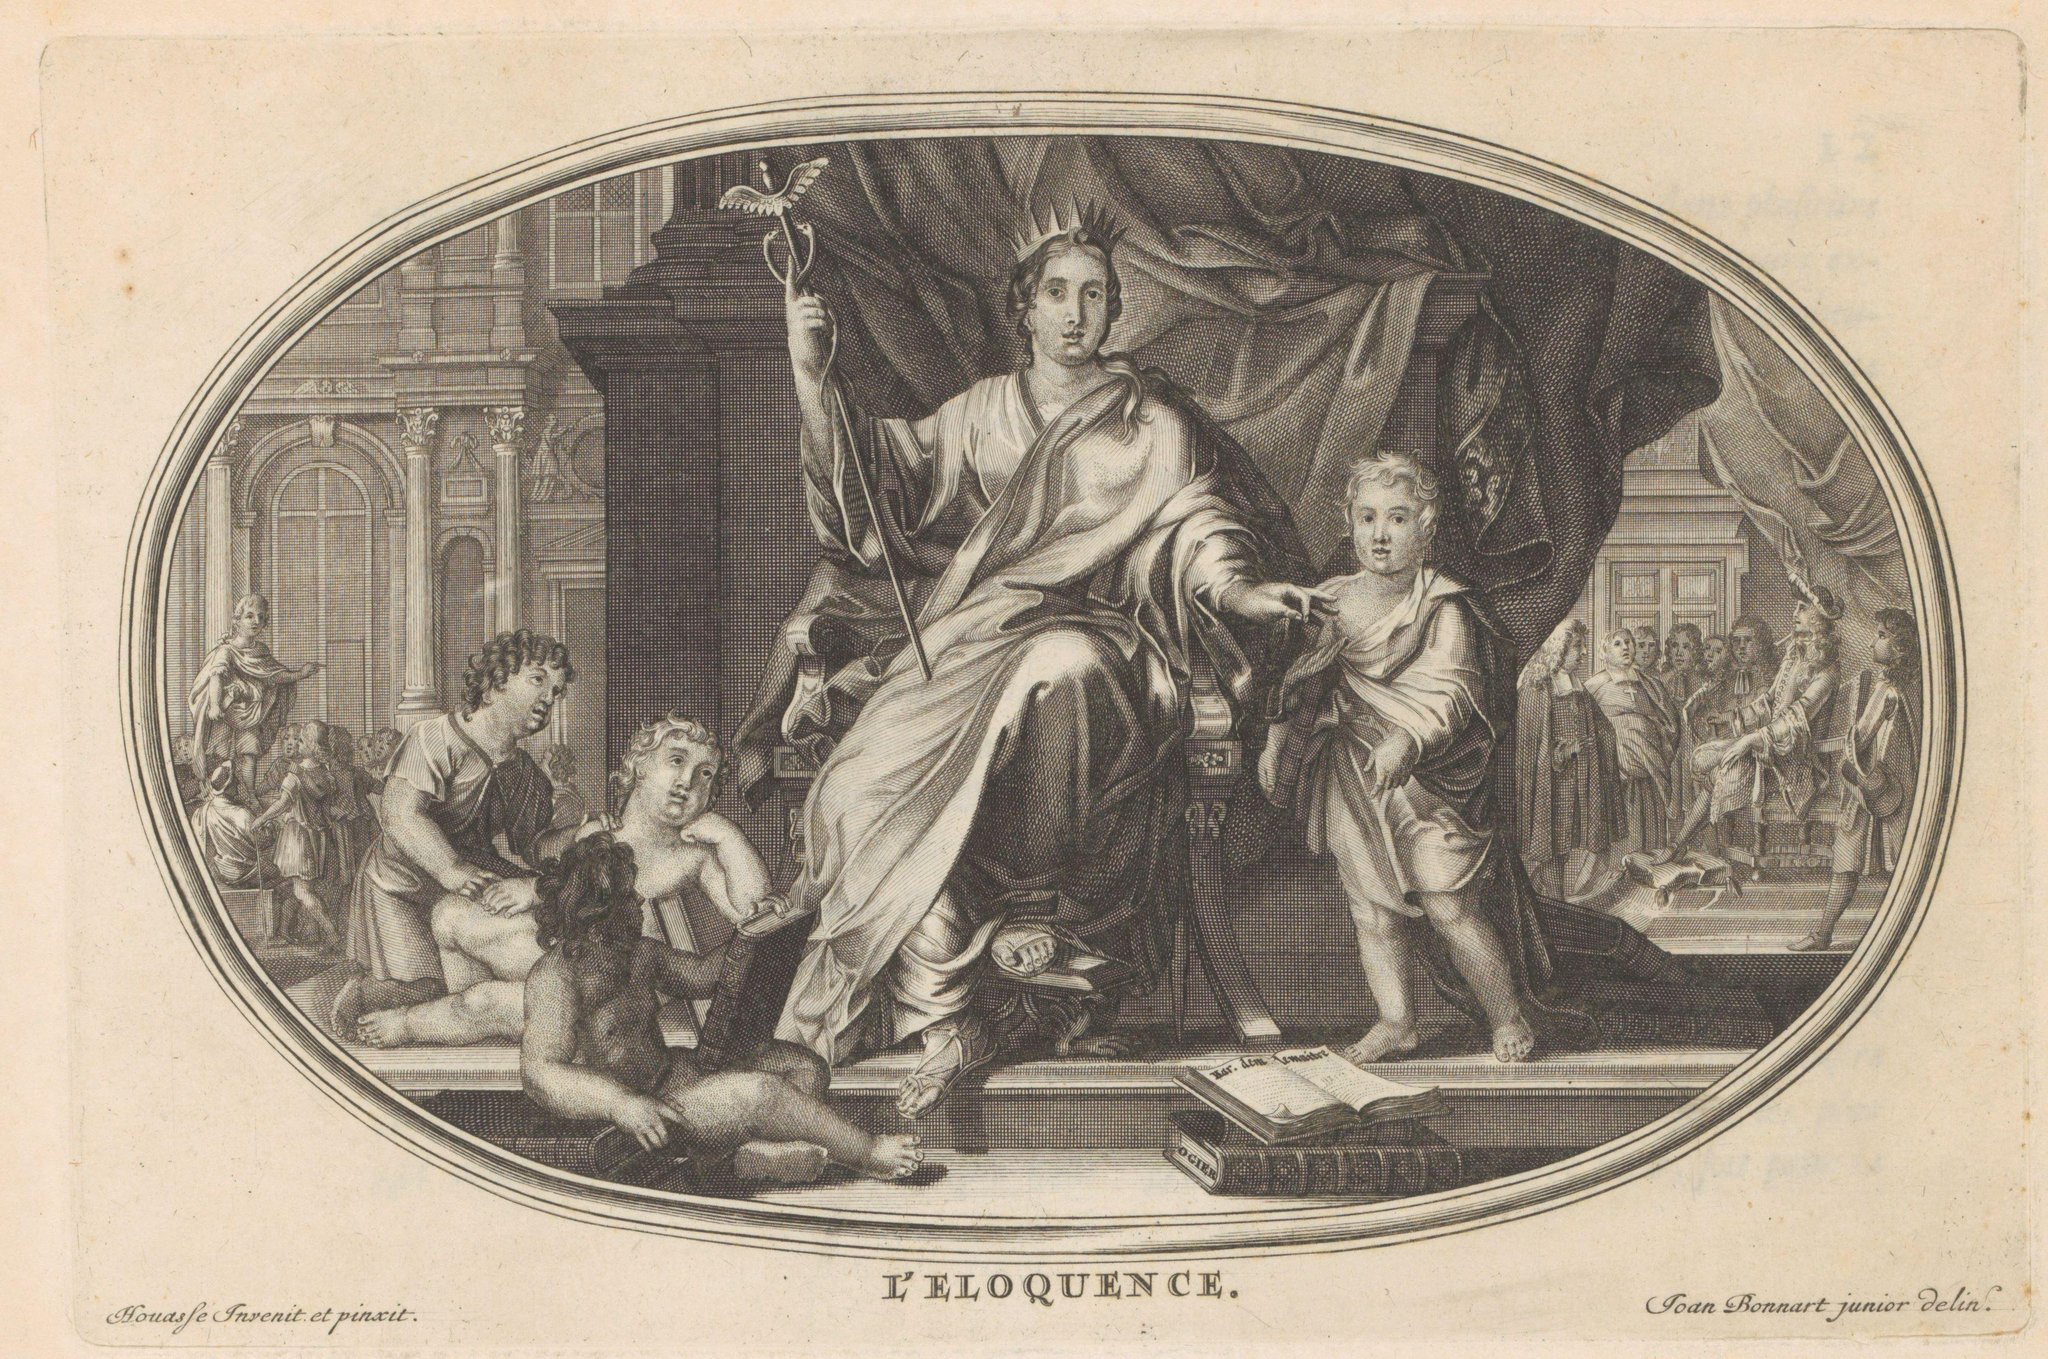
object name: album leaf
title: L'Eloquence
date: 1695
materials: paper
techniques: engraving, etching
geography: paris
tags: eloquence; 'eloquenza', 'fermezza & gravità dell'oratione' (ripa), (decorated) ceiling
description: Plafondstuk met de gepersonifieerde Welsprekendheid, gezeten op een troon met staf in de hand en kroon op het hoofd. Rondom haar putti met boeken. Op de achtergrond links een man die voor een menigte preekt in de Franse Academie en rechts koning Lodewijk XIV op zijn troon. Prent maakt deel uit van een album.